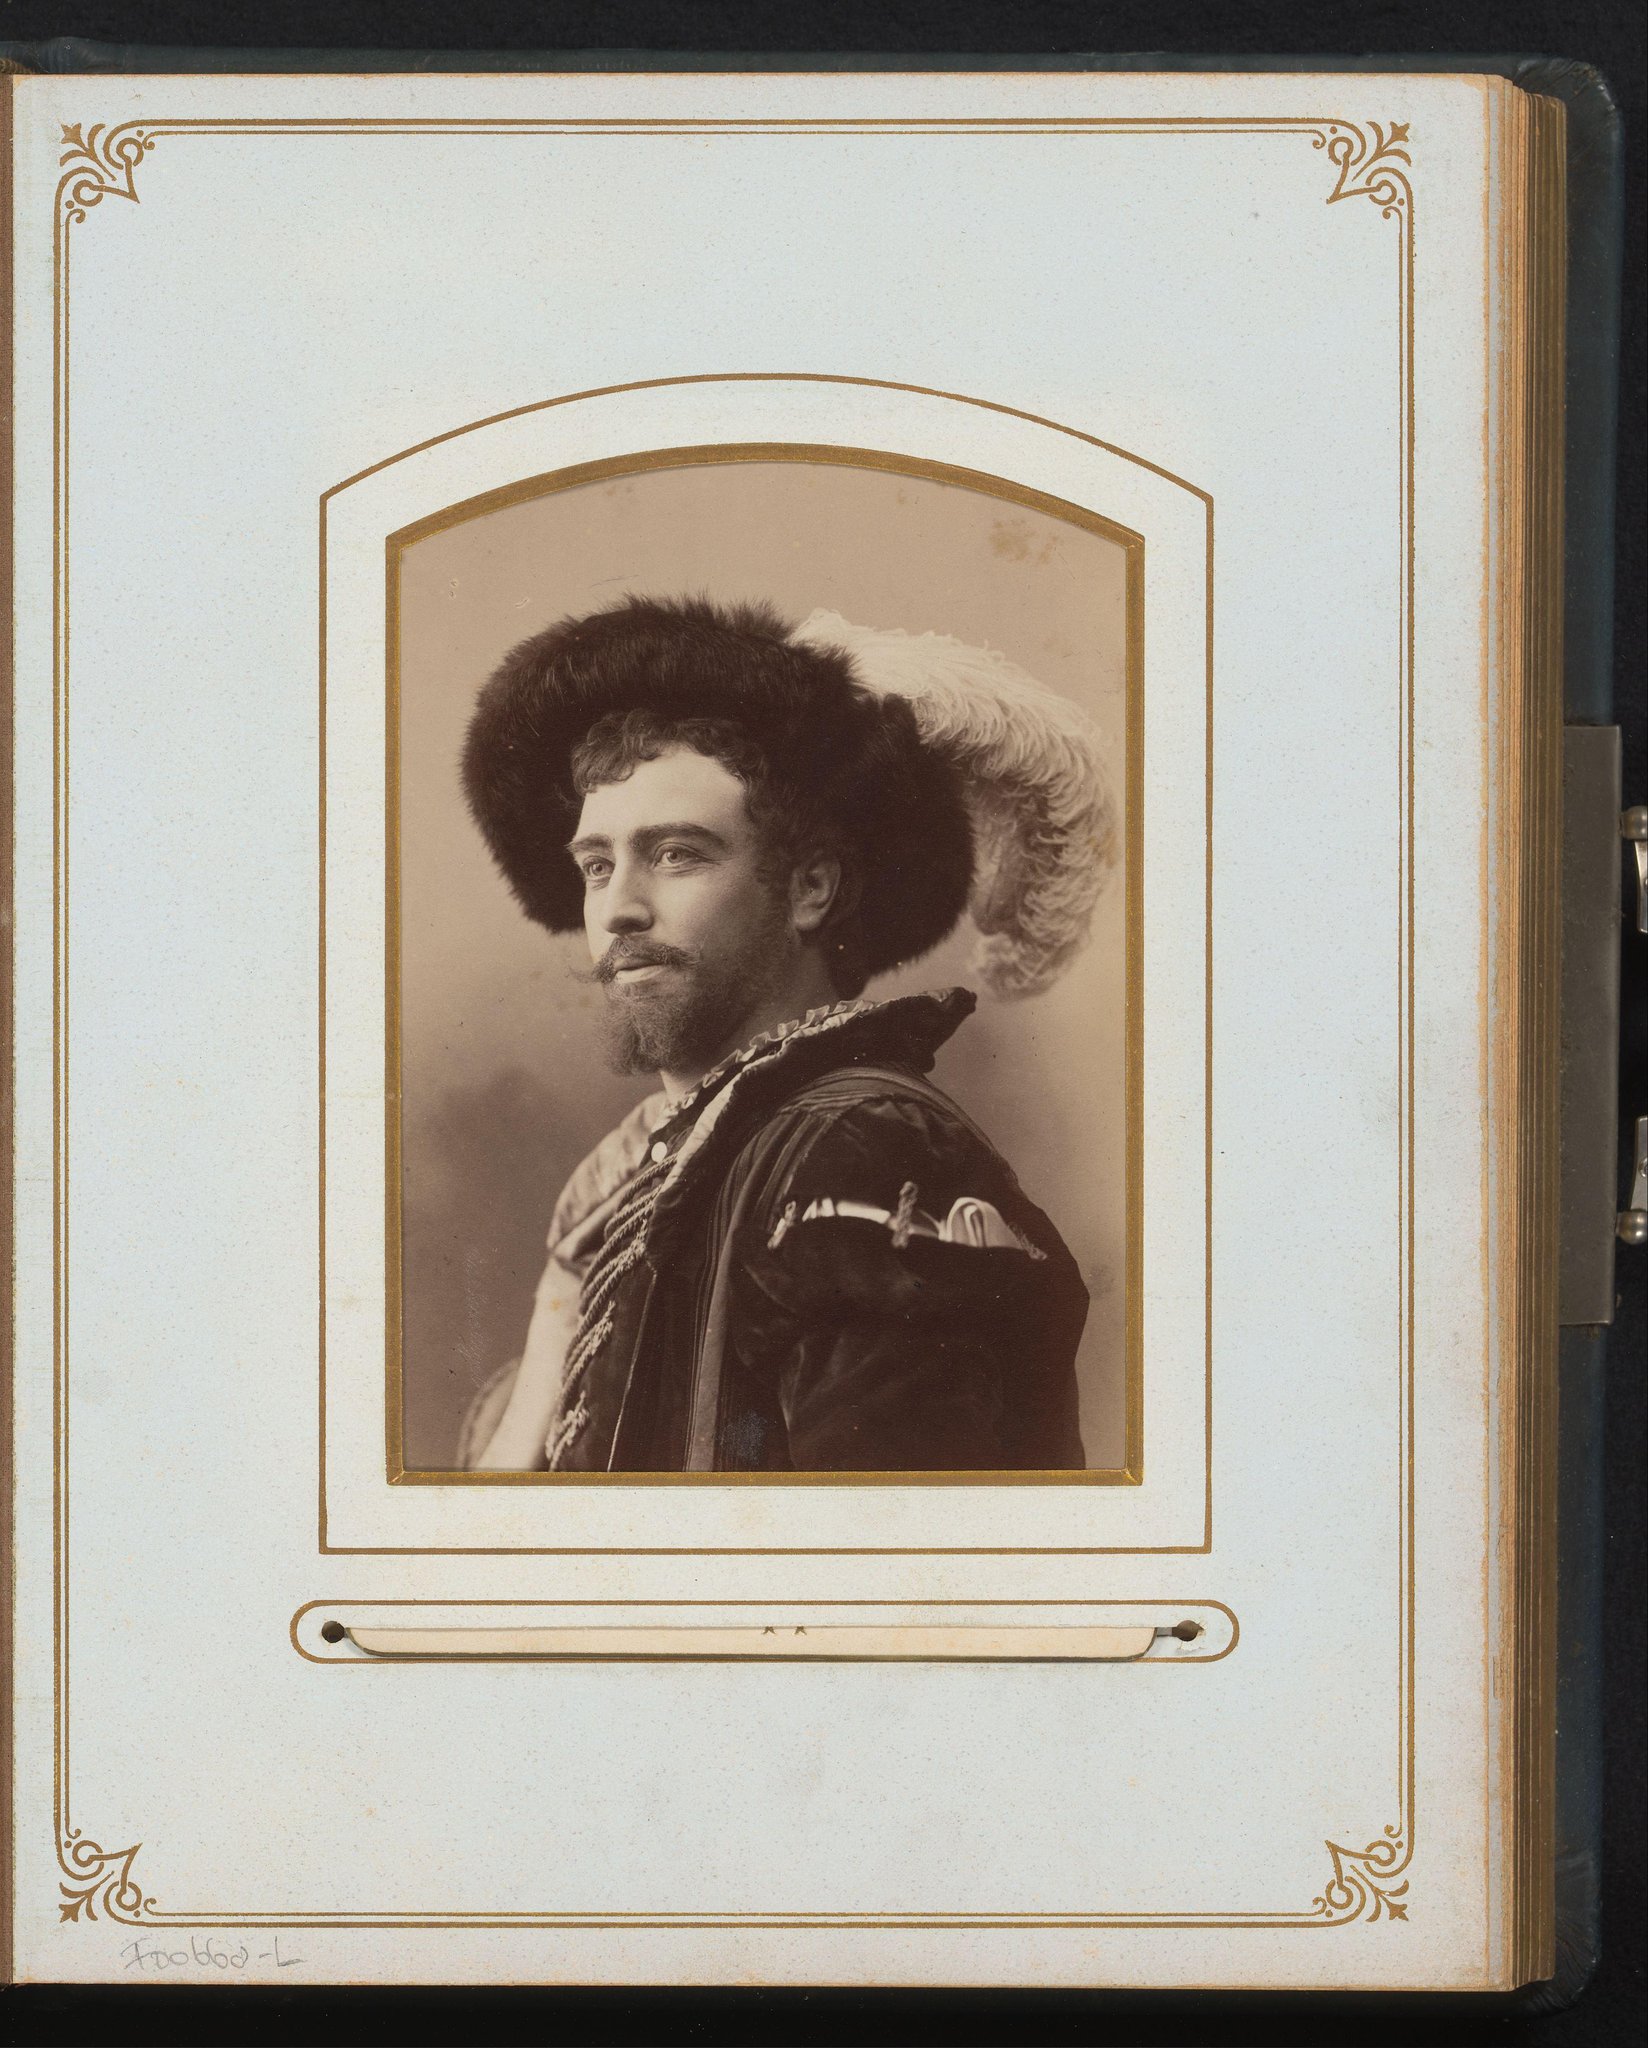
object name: photograph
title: Portret van een acteur als Faust met baret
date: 1890-1910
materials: cardboard, photographic support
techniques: albumen print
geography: copenhagen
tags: historical persons, portrait of actor, actress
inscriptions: annotation: ‘Herald als Faust/ Kopenhagen’